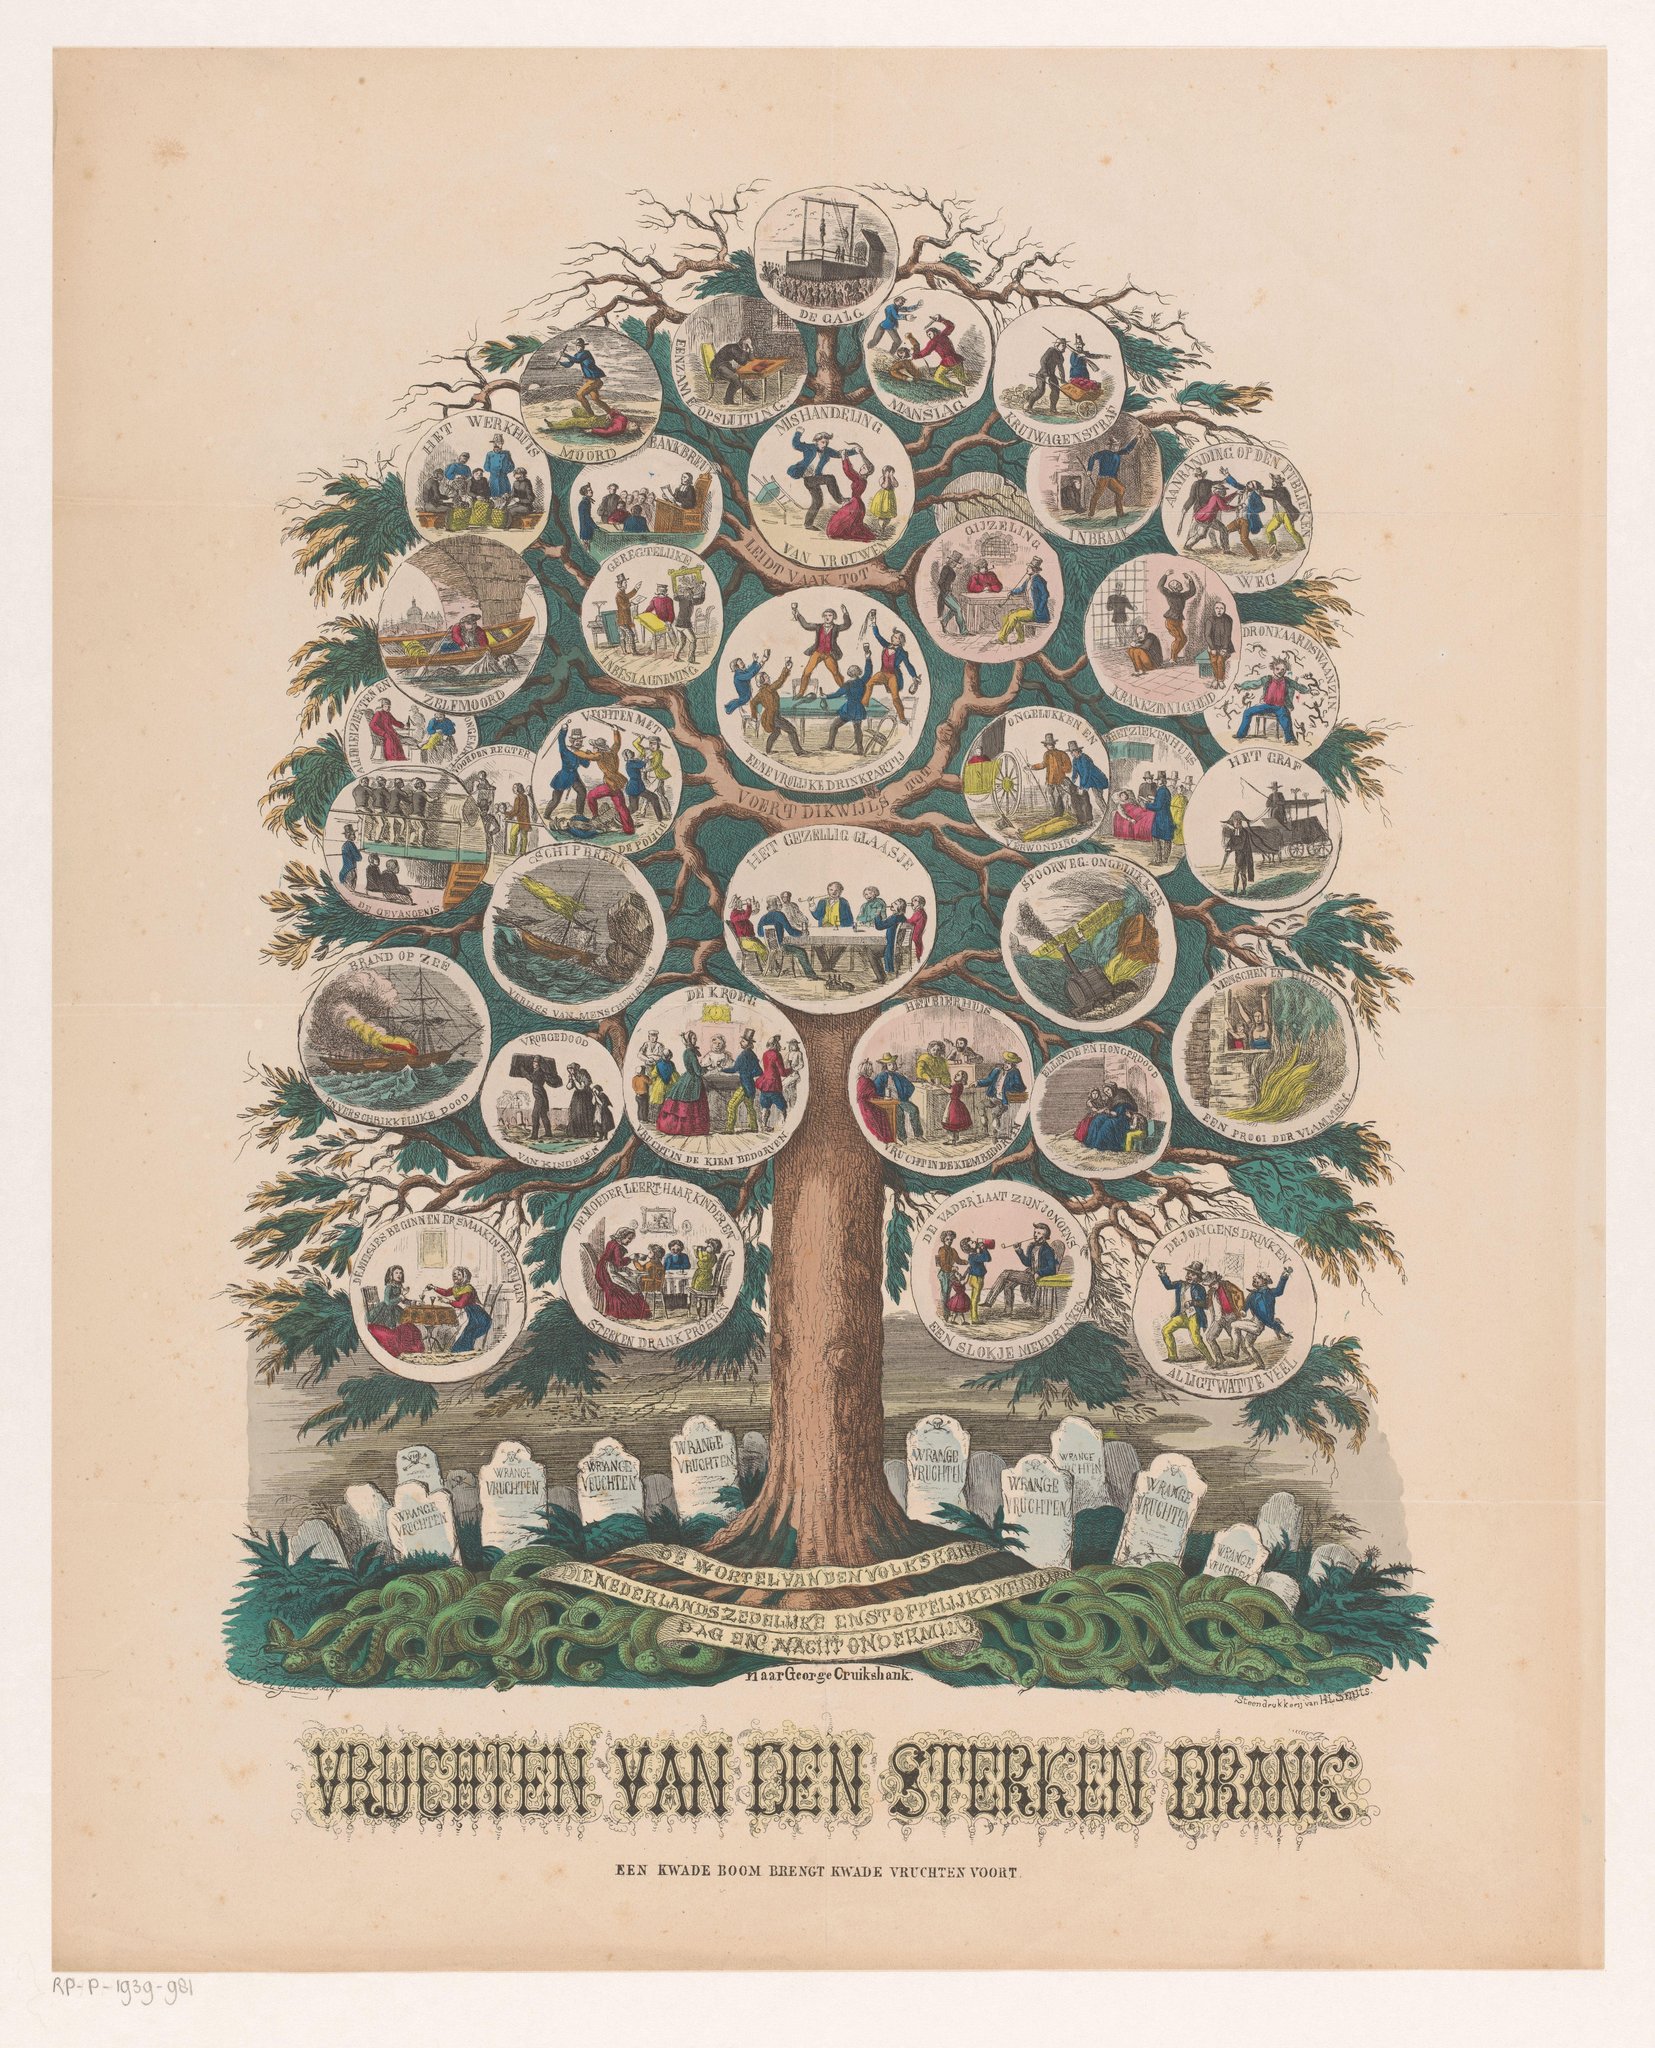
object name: print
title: Vruchten van den sterken drank, een kwade boom brengt kwade vruchten voort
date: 1864-1897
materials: paper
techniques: lithograph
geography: the hague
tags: drunkenness, alcoholic drinks, drinking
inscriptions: collector's mark: Lugt 2760, collector's mark: Lugt 2228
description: Een boom waarin medaillons met scènes met de gevolgen van het drinken van sterke drank. Onder de boom krioelen slangen en staan grafstenen.